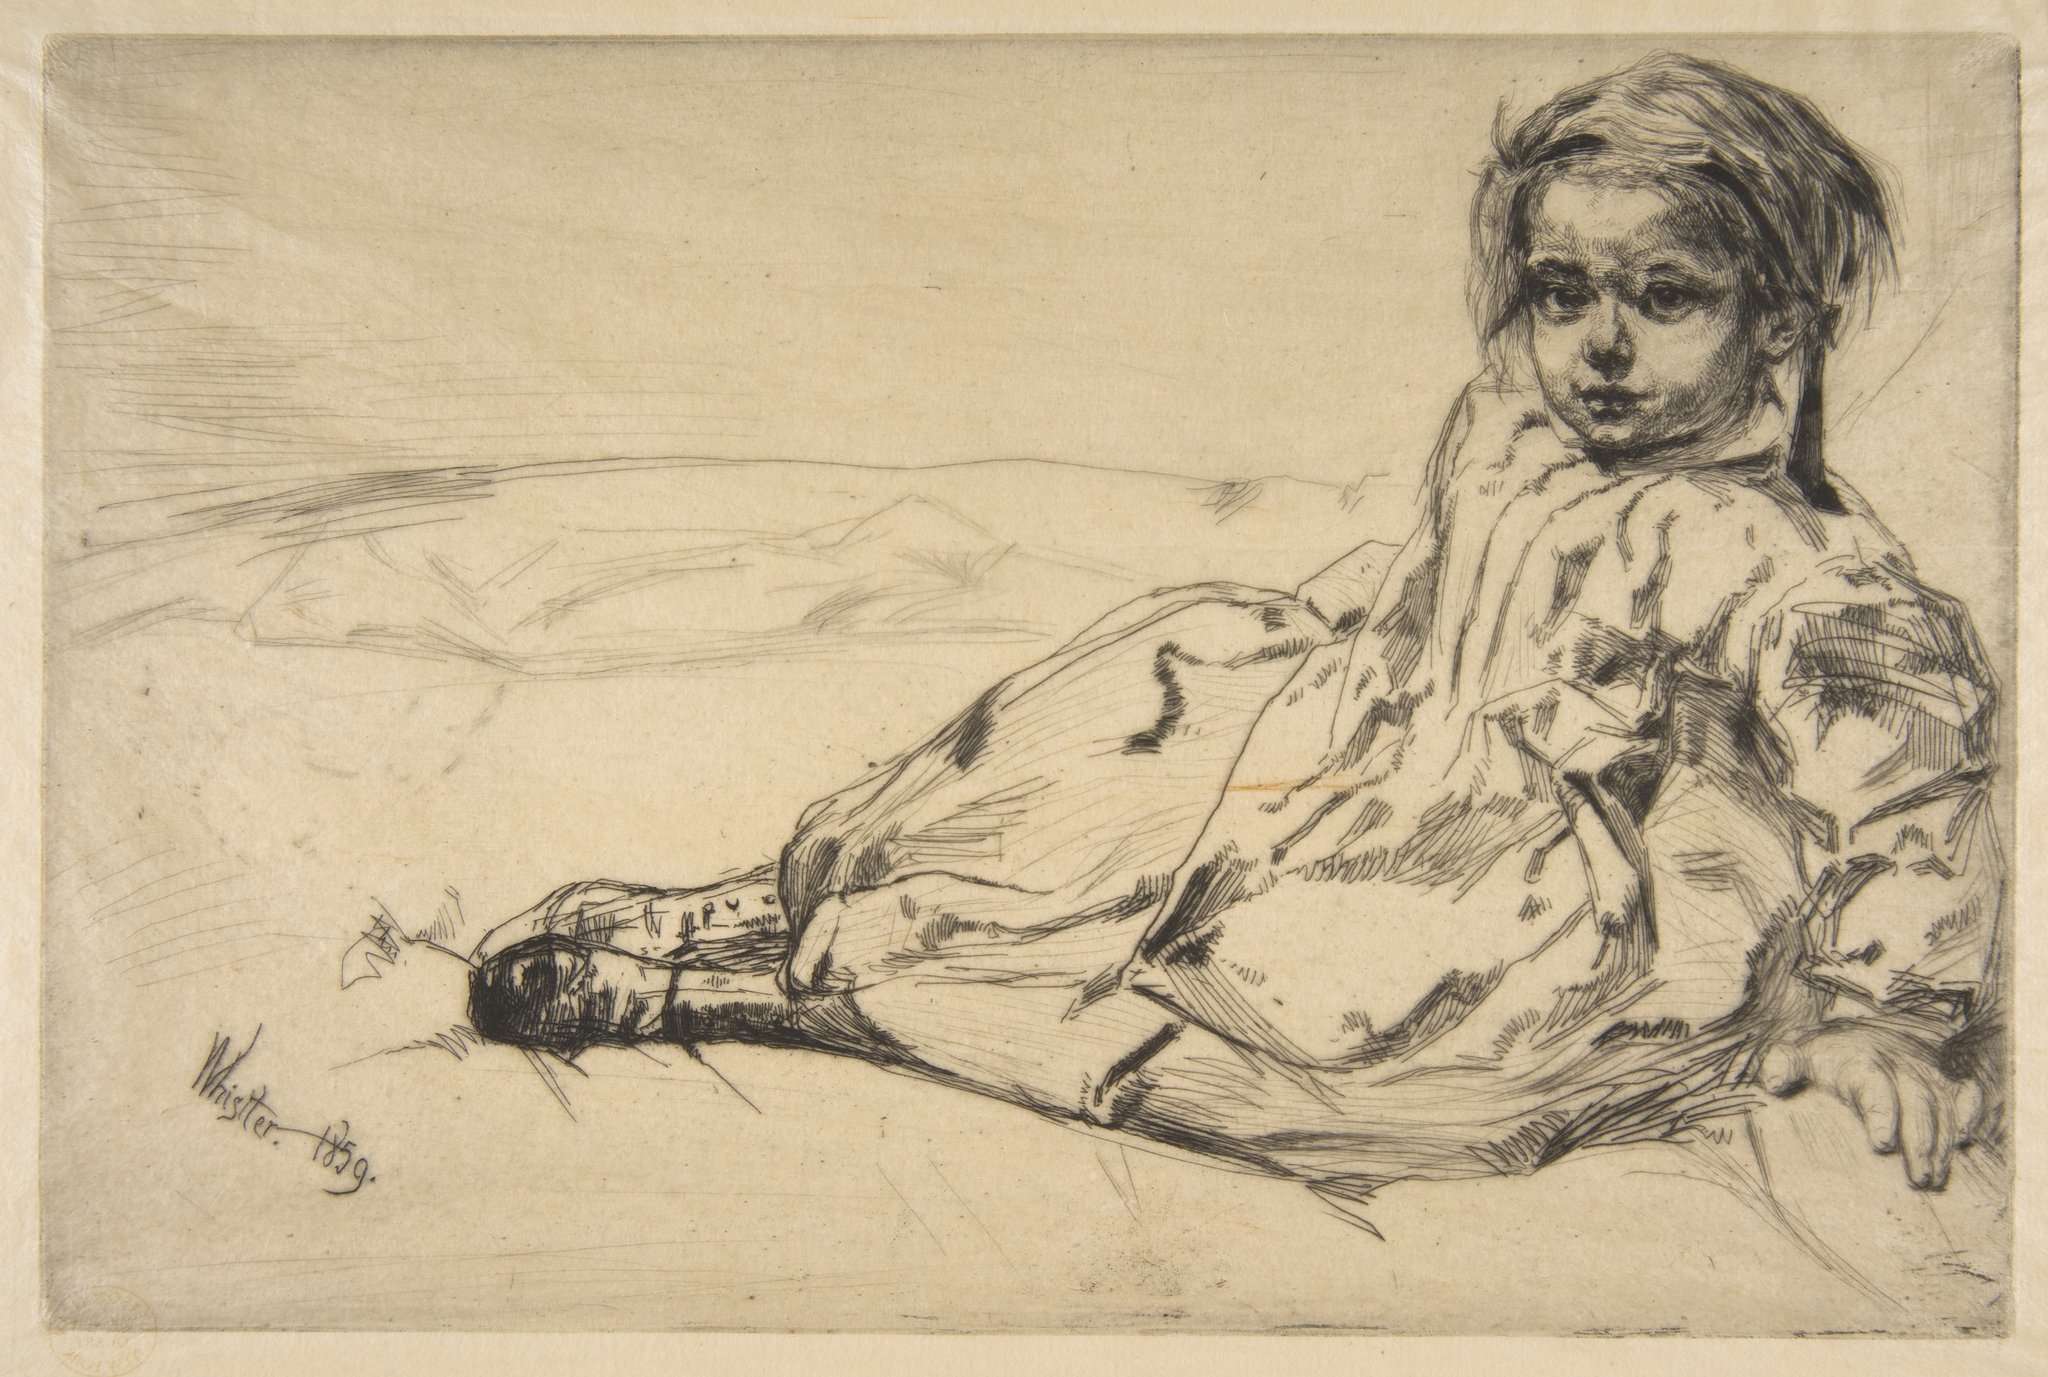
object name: print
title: Bibi Valentin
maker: james mcneill whistler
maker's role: artist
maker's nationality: american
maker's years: 1834-1903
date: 1859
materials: ink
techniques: drypoint, etching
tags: girls